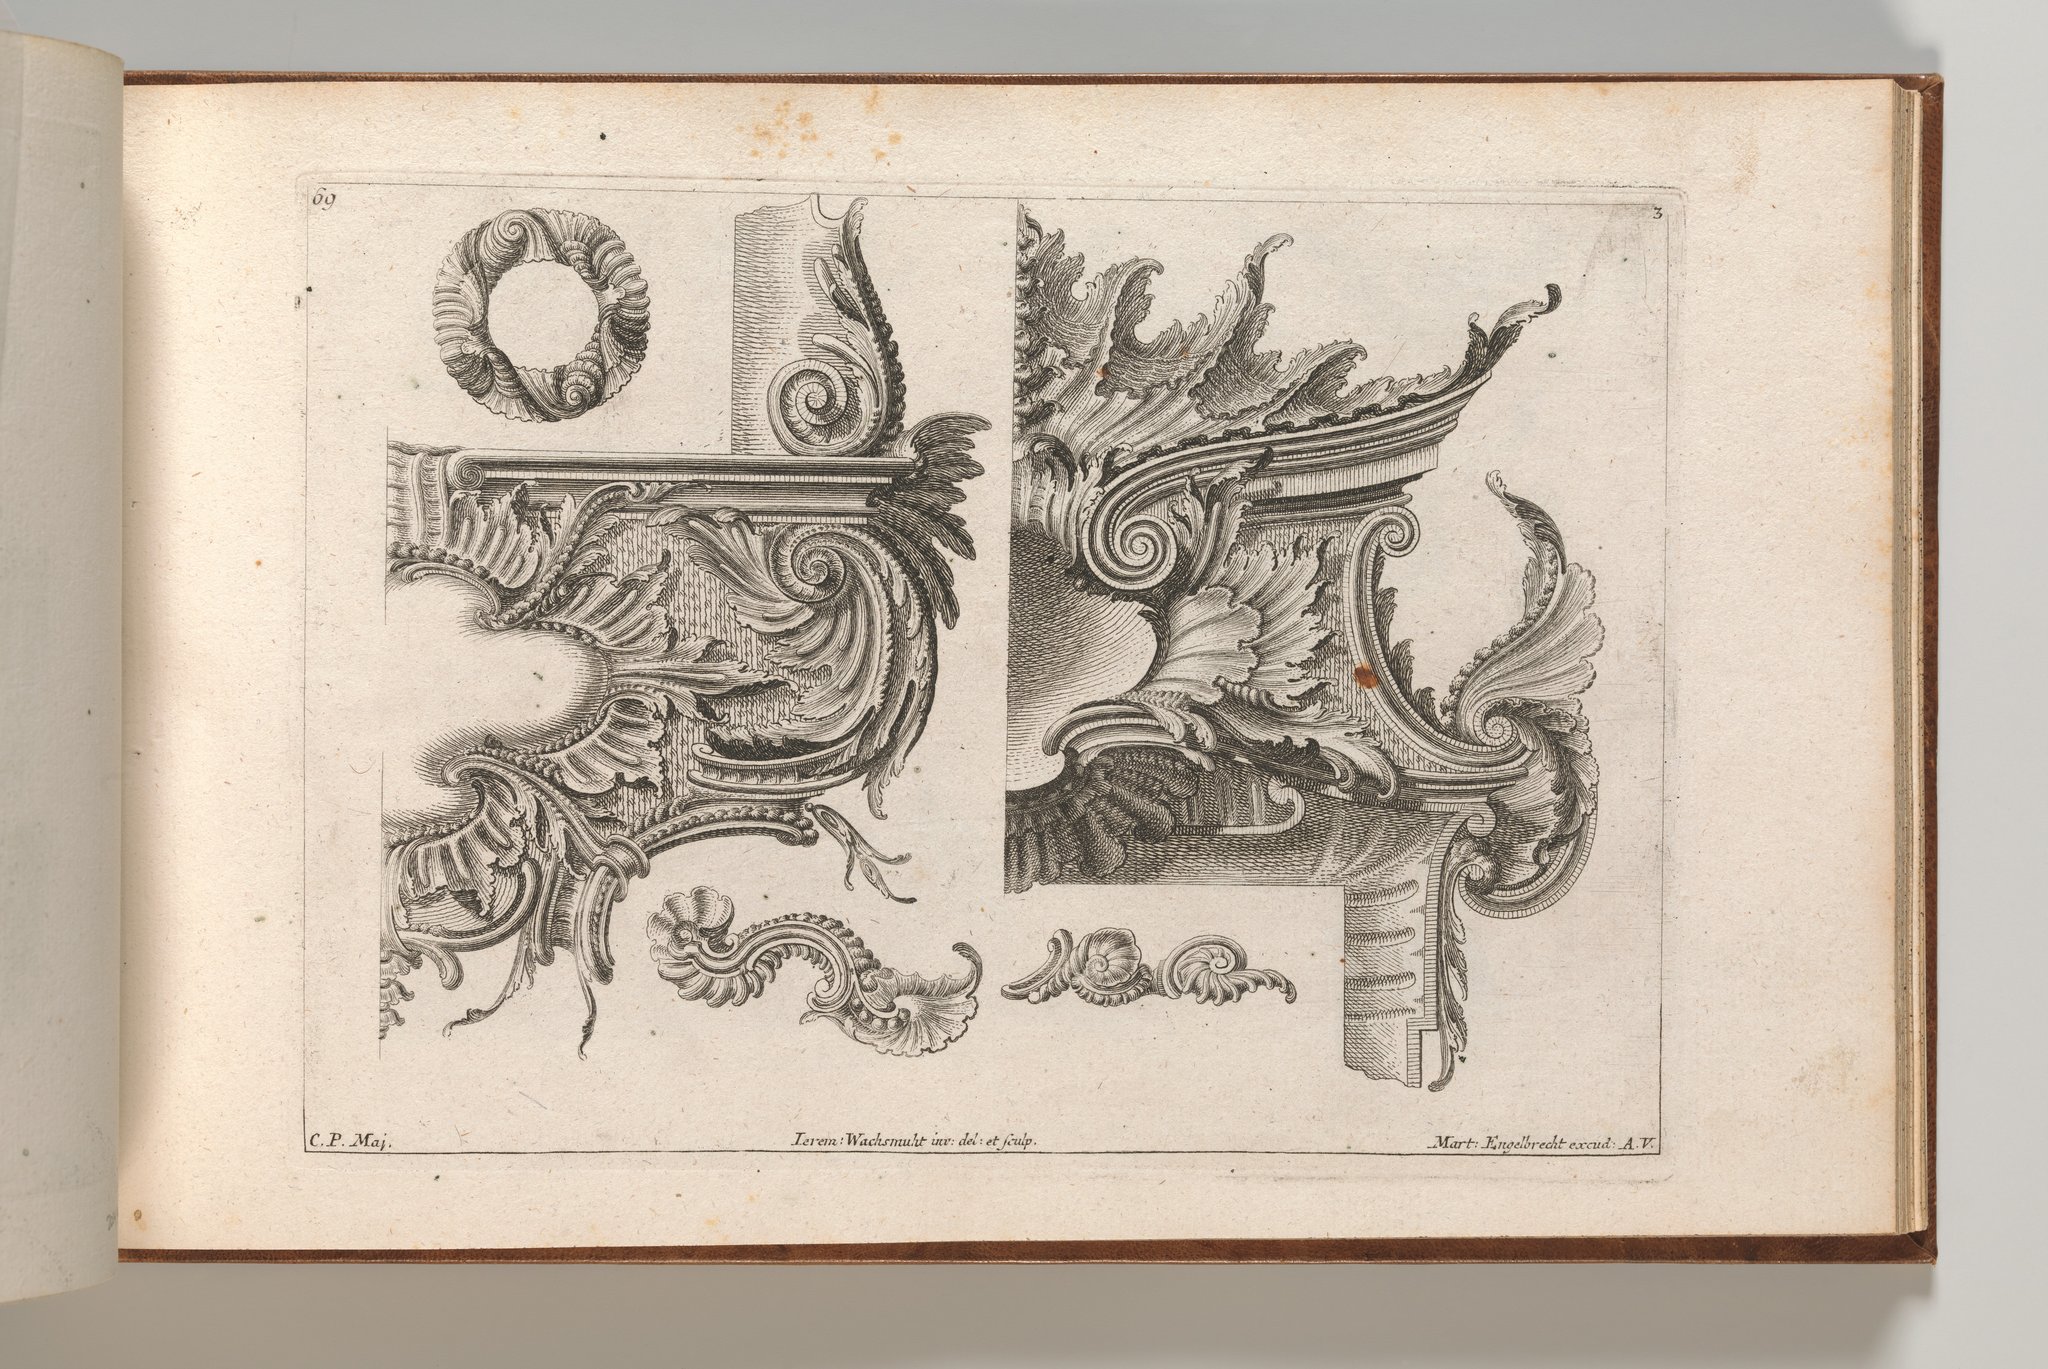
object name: album print ornament architecture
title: Suggestion for the Decoration of the Lower and Top Right of a Frame Combined with Several Additional Ornaments, Plate 3 from: 'Unterschidliche Auszierungen zu Thüren und Fenster, etc. etc. sehr nutzlich zu gebrauchen'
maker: jeremias wachsmuth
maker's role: artist and engraver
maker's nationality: german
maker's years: 1712-1771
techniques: etching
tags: ornament